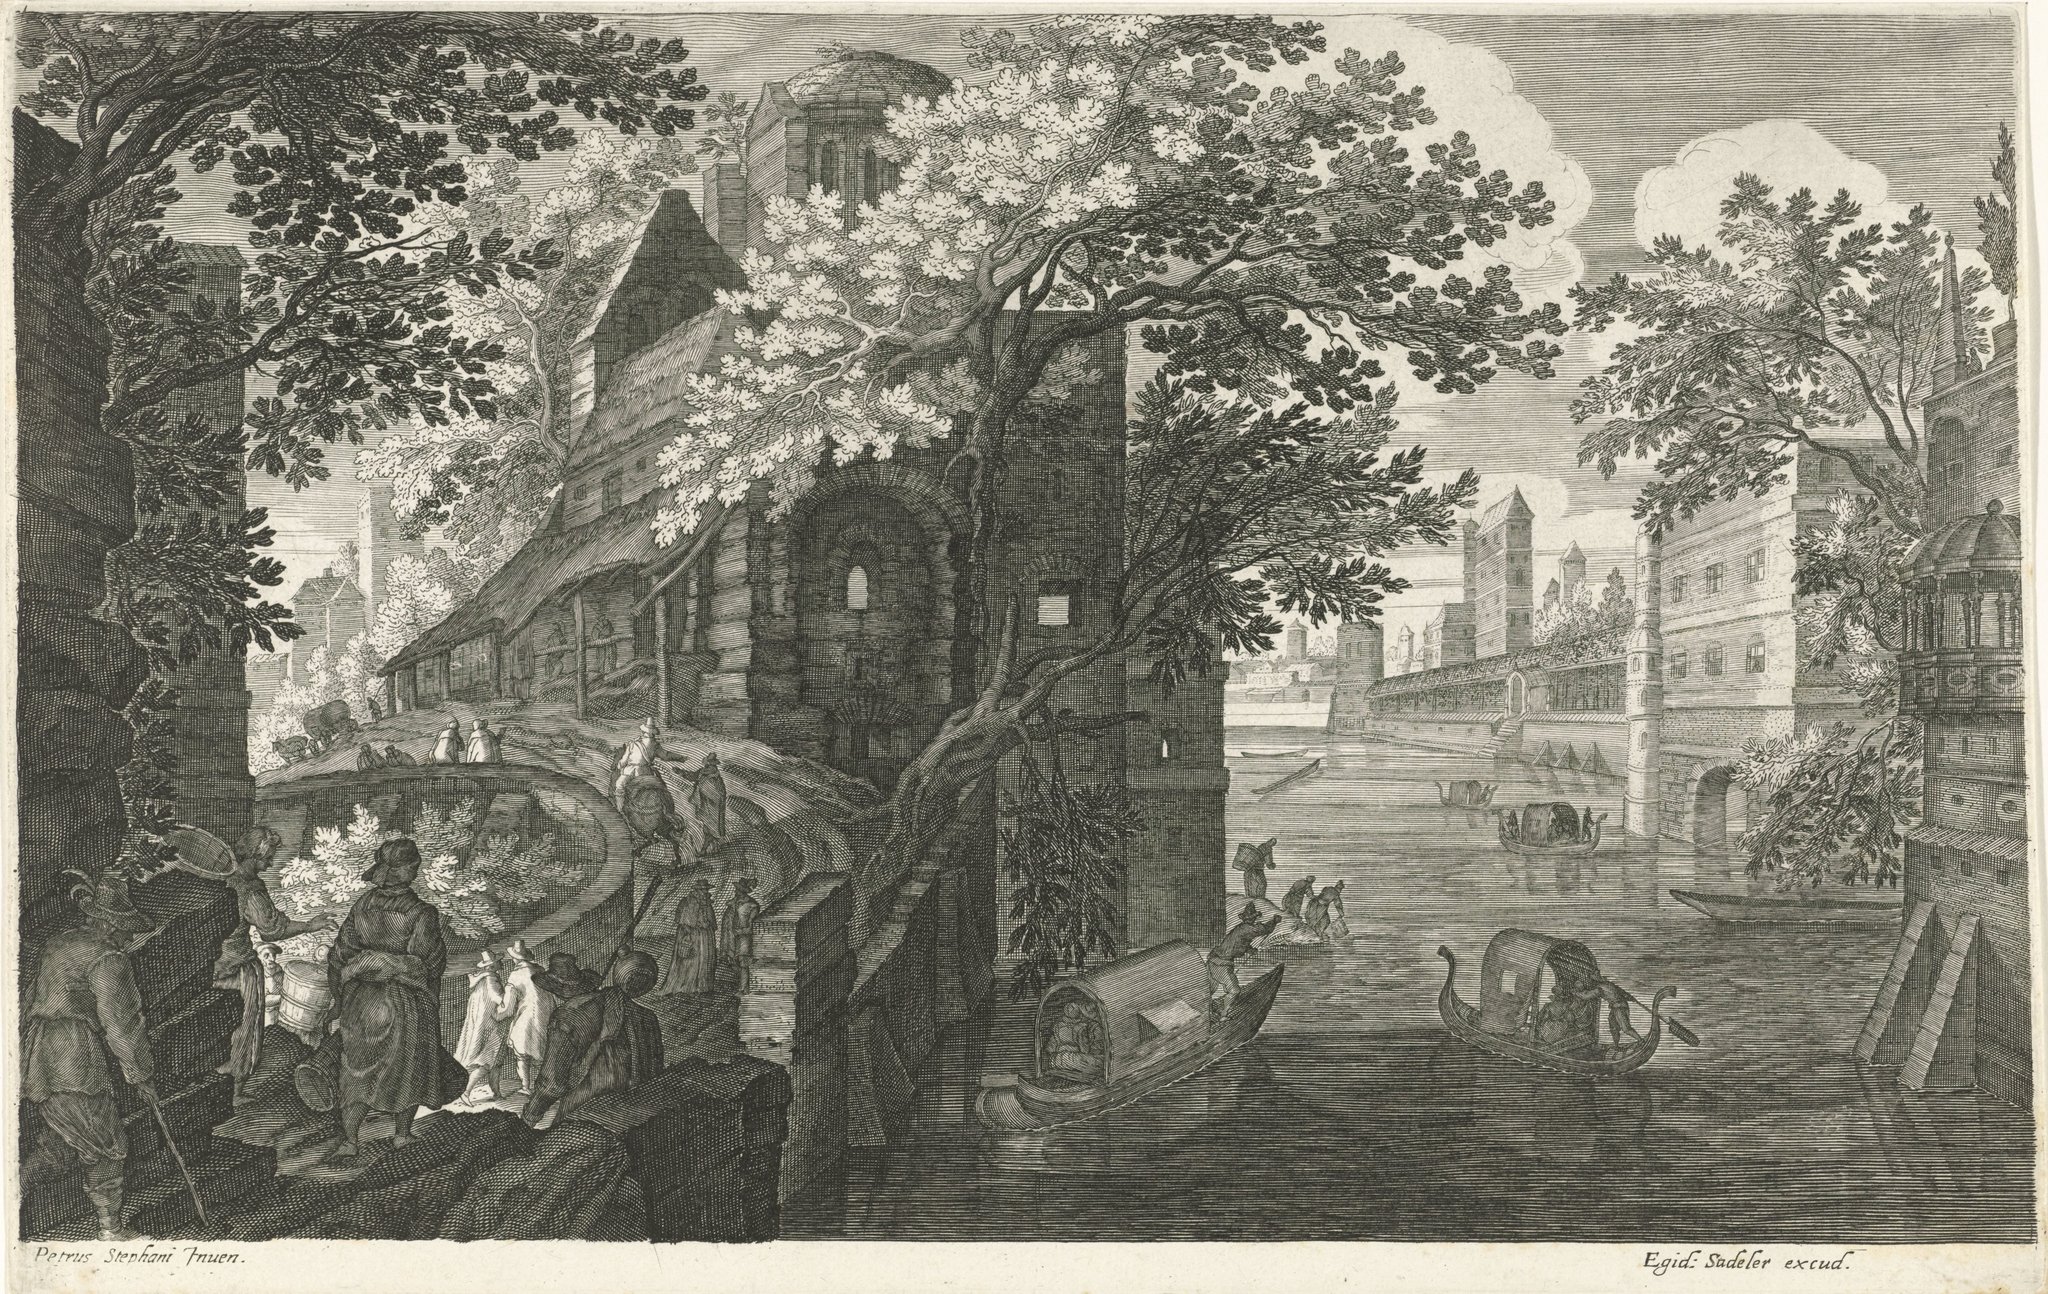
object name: print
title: Gondels op een kanaal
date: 1597-1629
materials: paper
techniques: engraving, etching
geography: prague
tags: gondola, 'en route', traveller under way, canals, waters (in city) (+ city(-scape) with figures, staffage)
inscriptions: collector's mark: Lugt 240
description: Gondels op een kanaal. Links een weg met reizigers. De vierde prent van een achtdelige reeks met landschappen in Bohemen